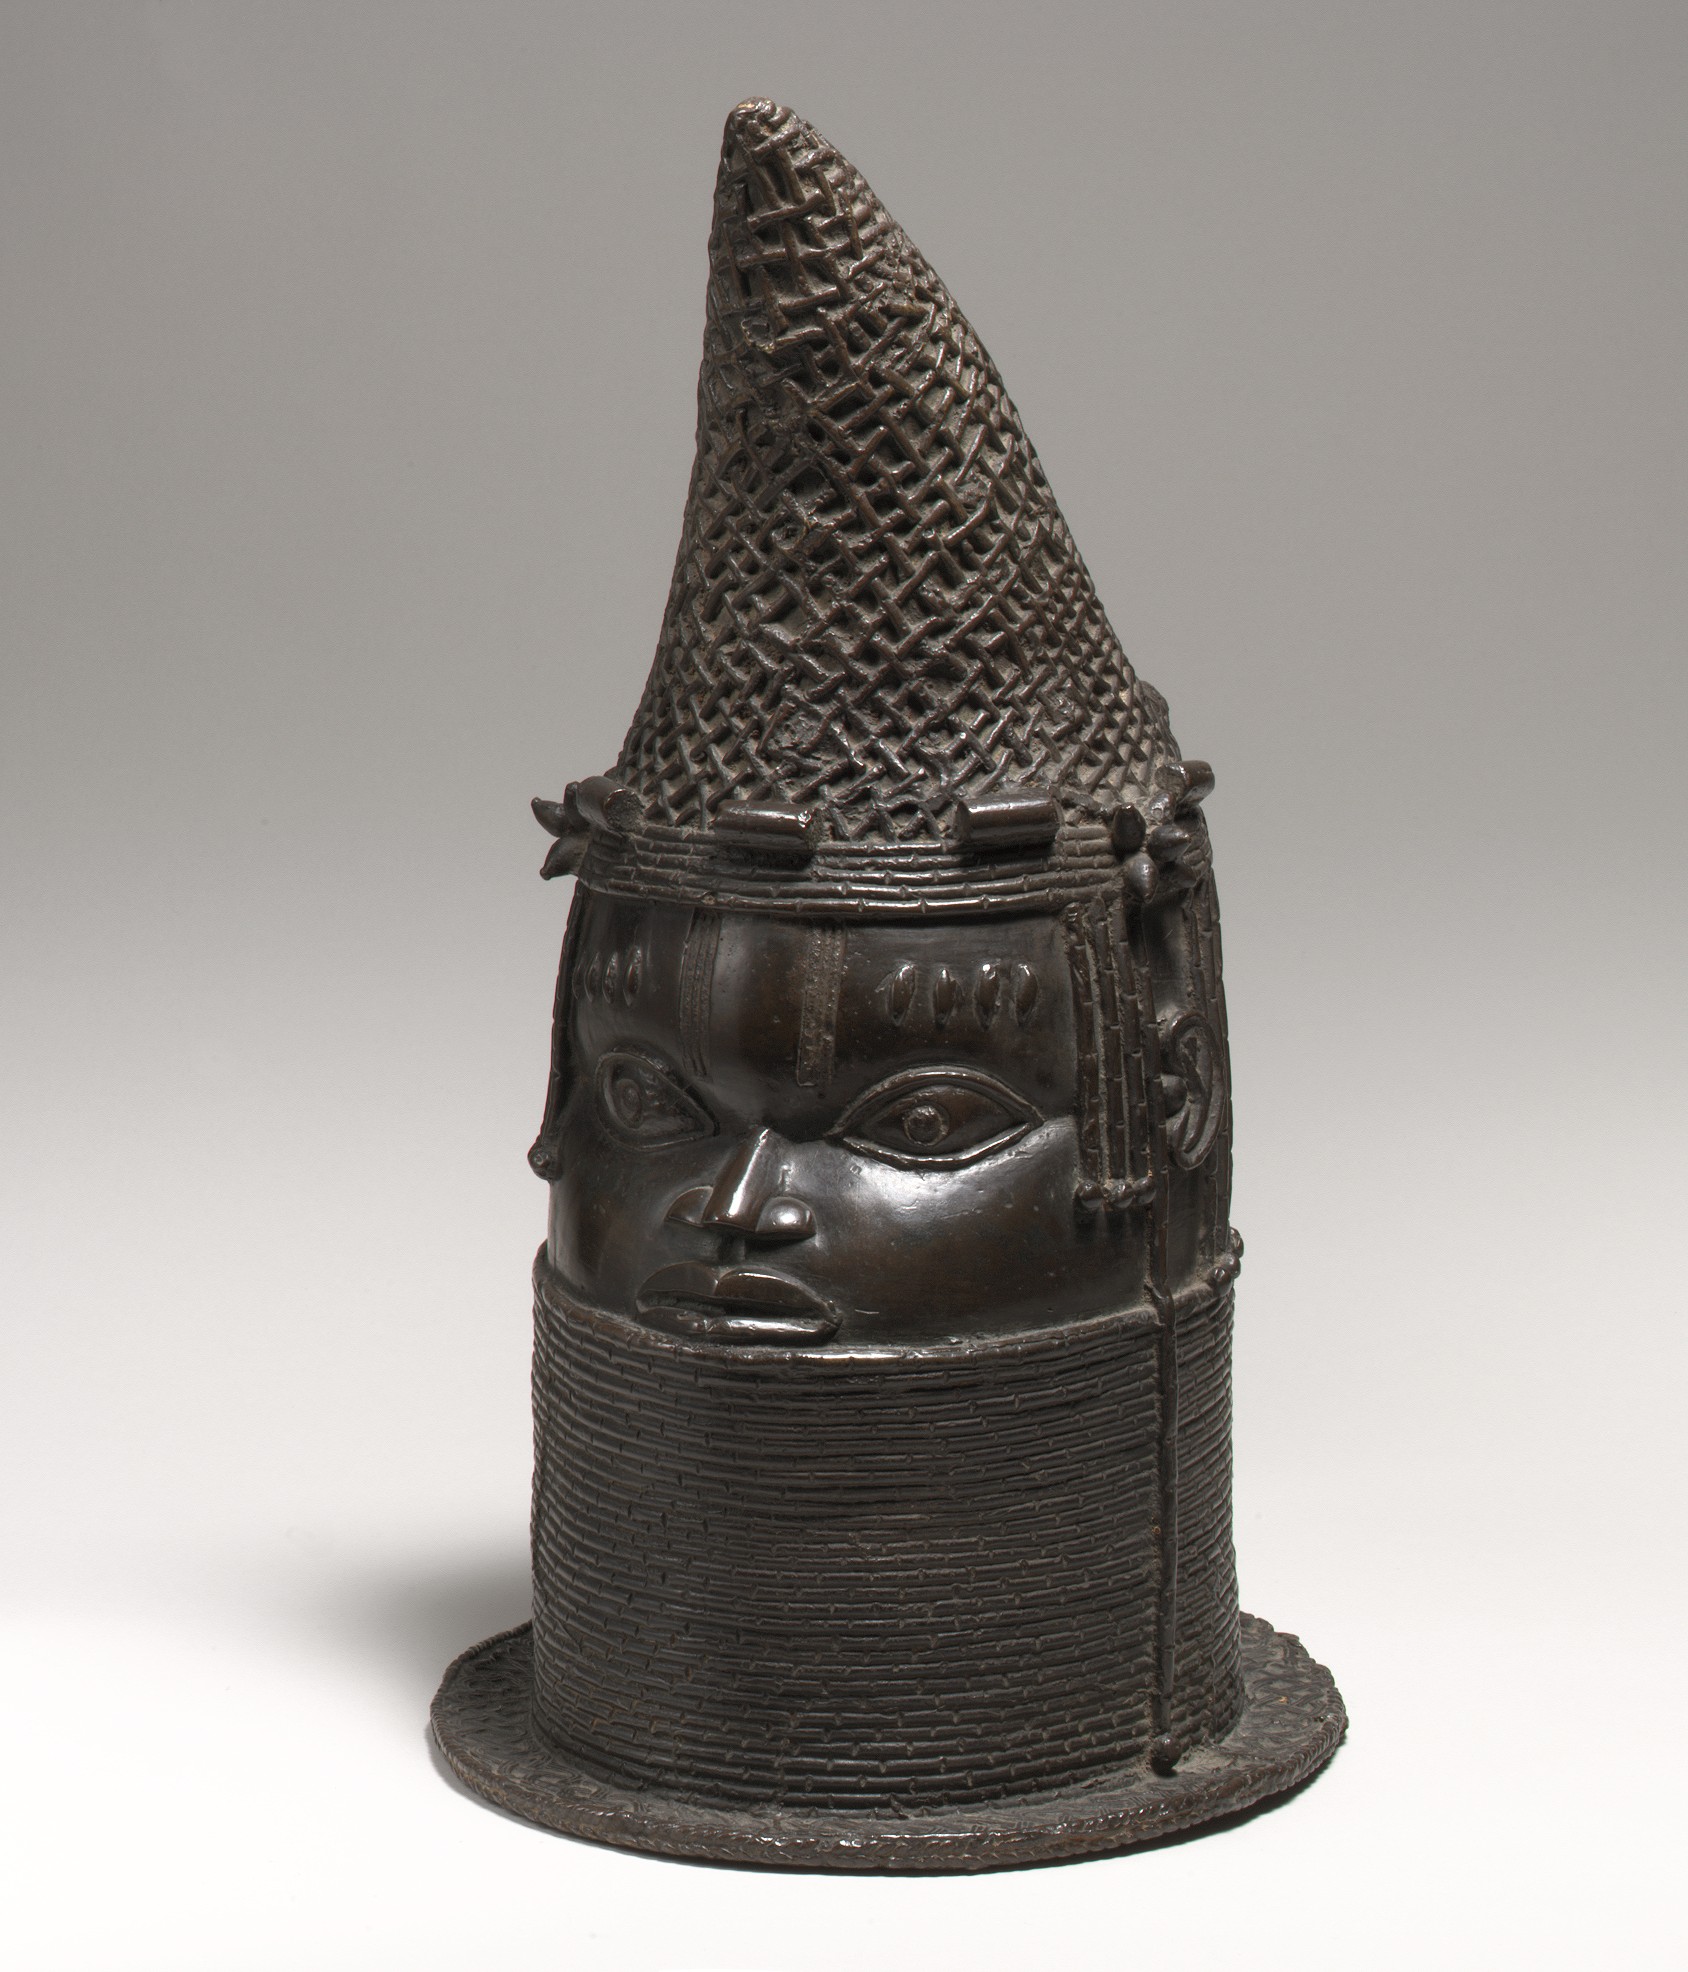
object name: head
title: Head of a Queen Mother (Iyoba)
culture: edo period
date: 1750-1800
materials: brass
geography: nigeria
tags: heads,women